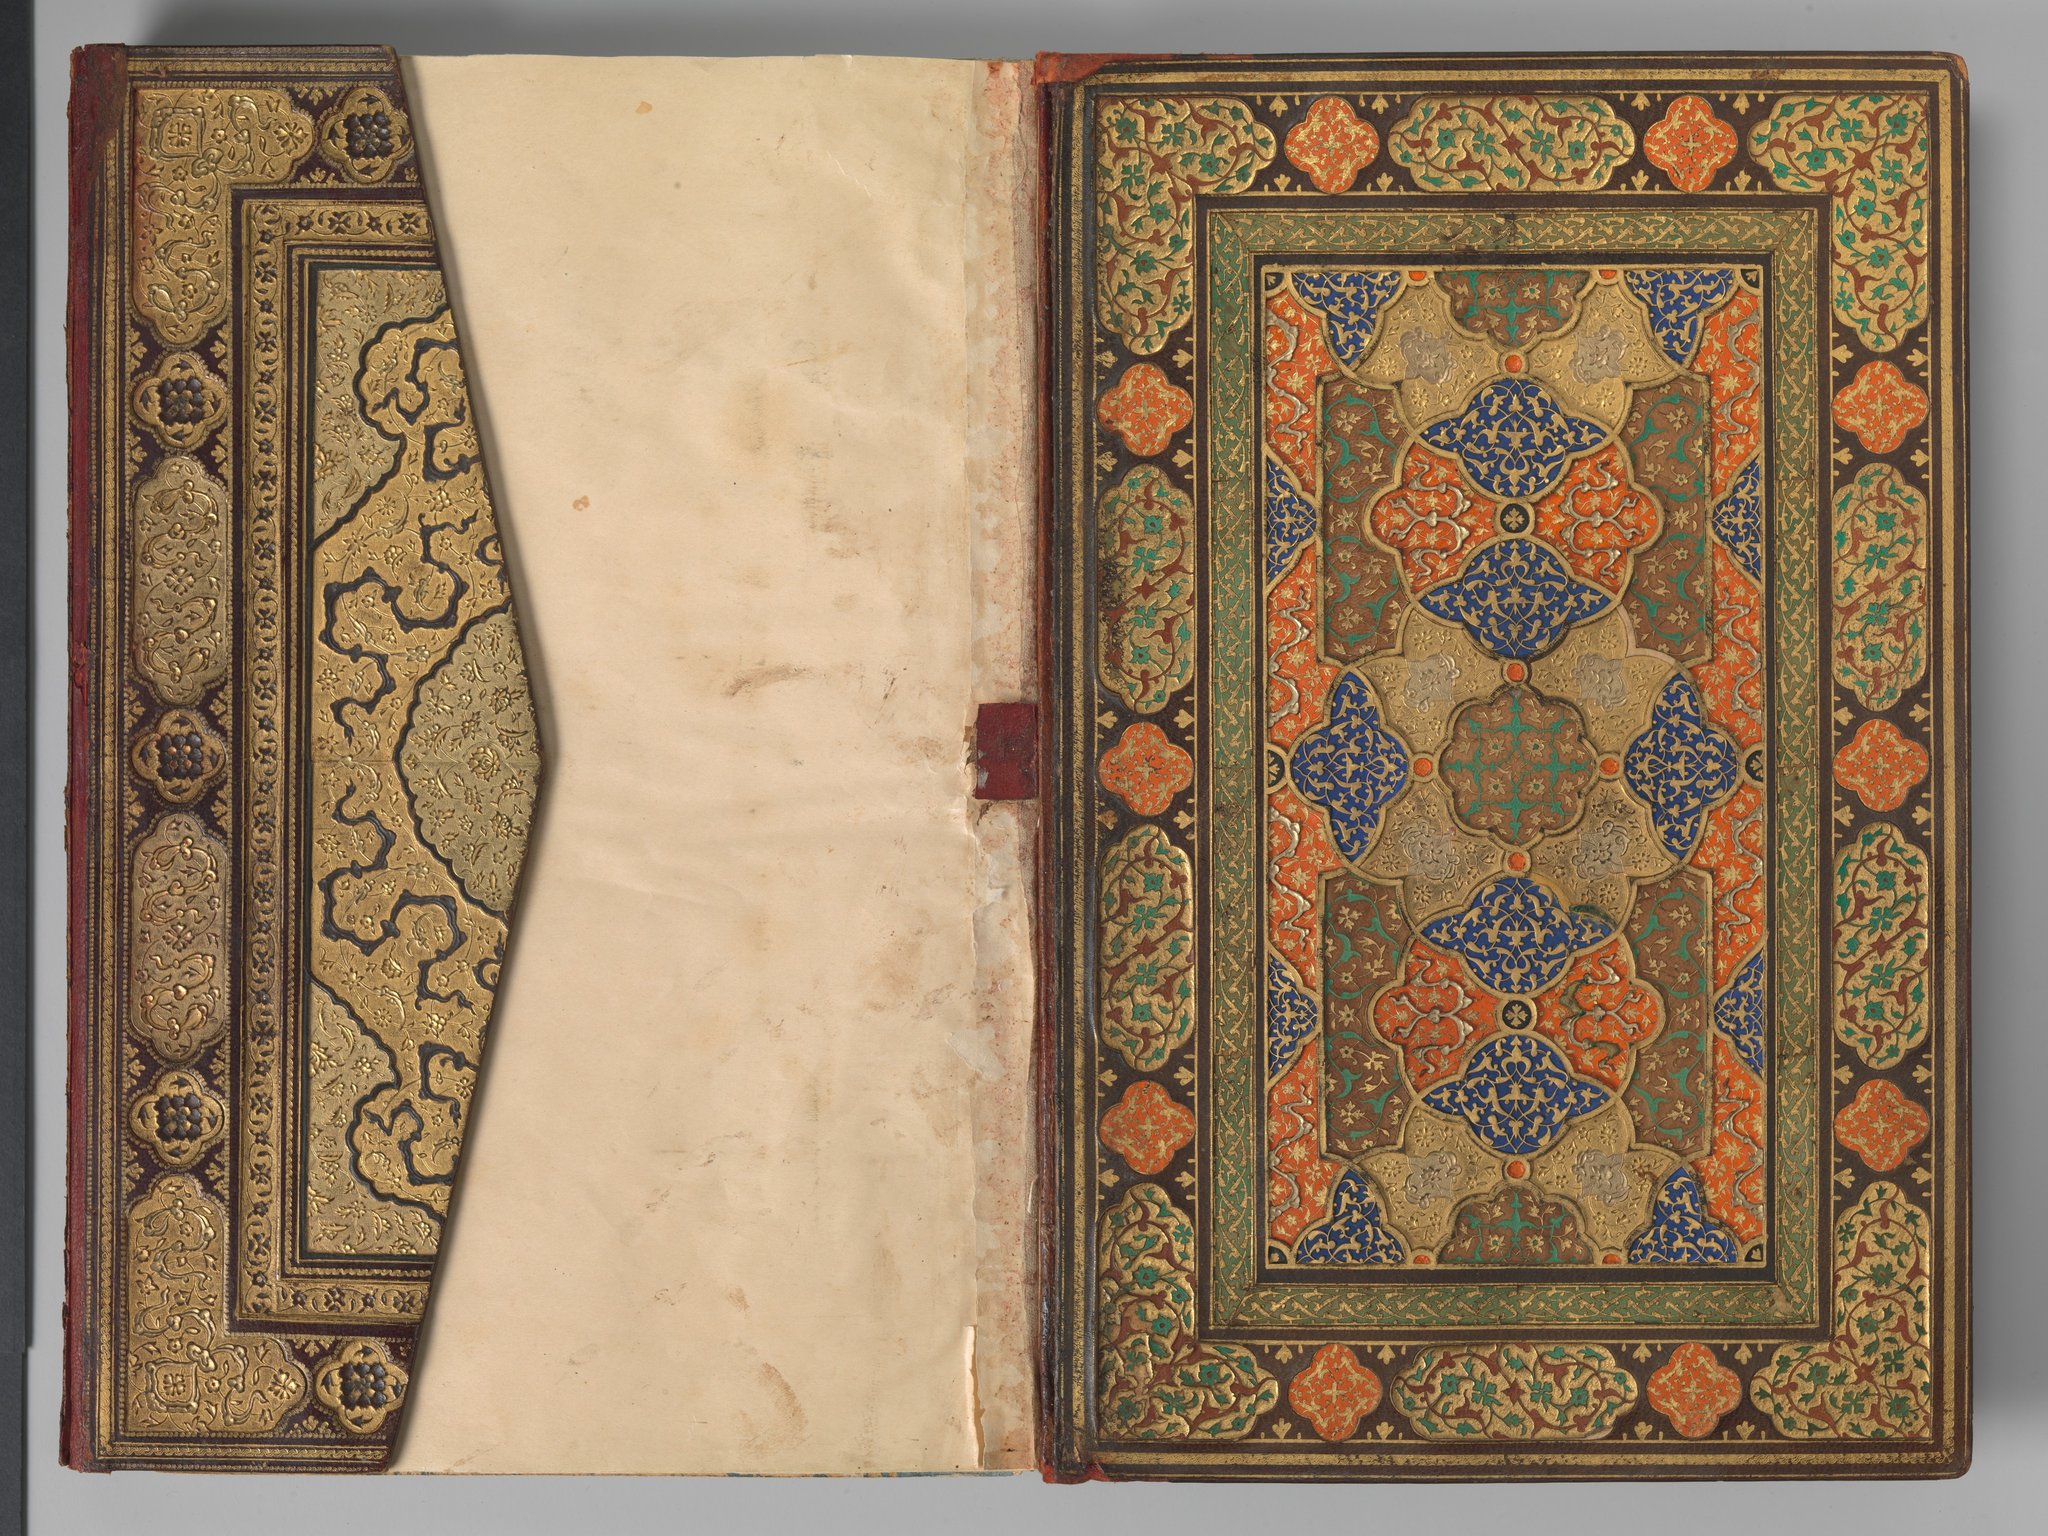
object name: illustrated manuscript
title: Mantiq al-Tayr (Language of the Birds)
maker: farid al-din `attar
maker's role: author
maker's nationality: iranian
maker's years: 1142-1220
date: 1600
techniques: bookbinding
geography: iran